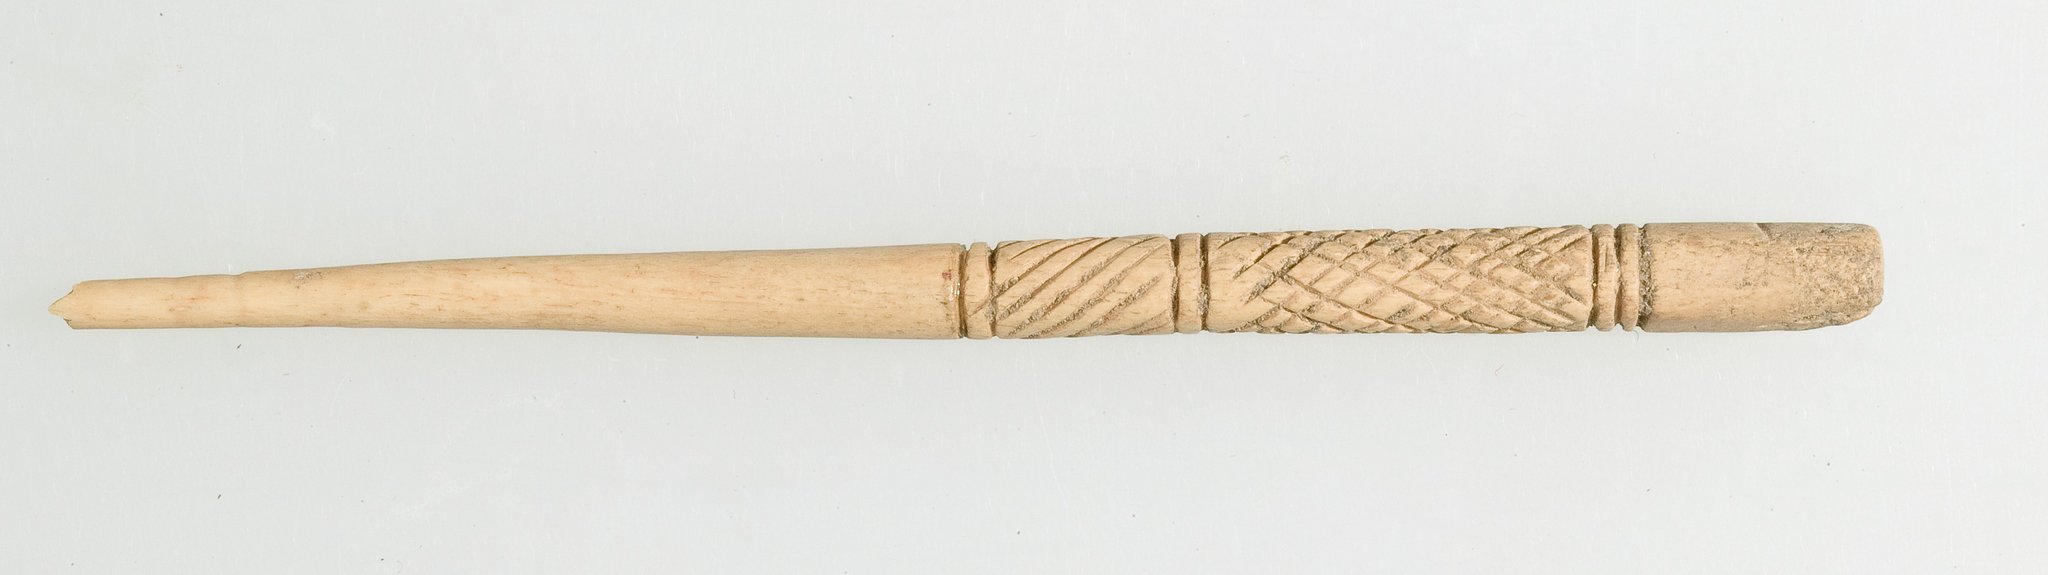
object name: hair pin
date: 1700-1550 BCE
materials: ivory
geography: egypt